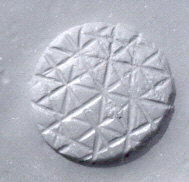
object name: stamp seal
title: Loop-handled circular seal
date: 5000-3001 BCE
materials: mineral, stone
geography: northern syria, mesopotamia or western iran